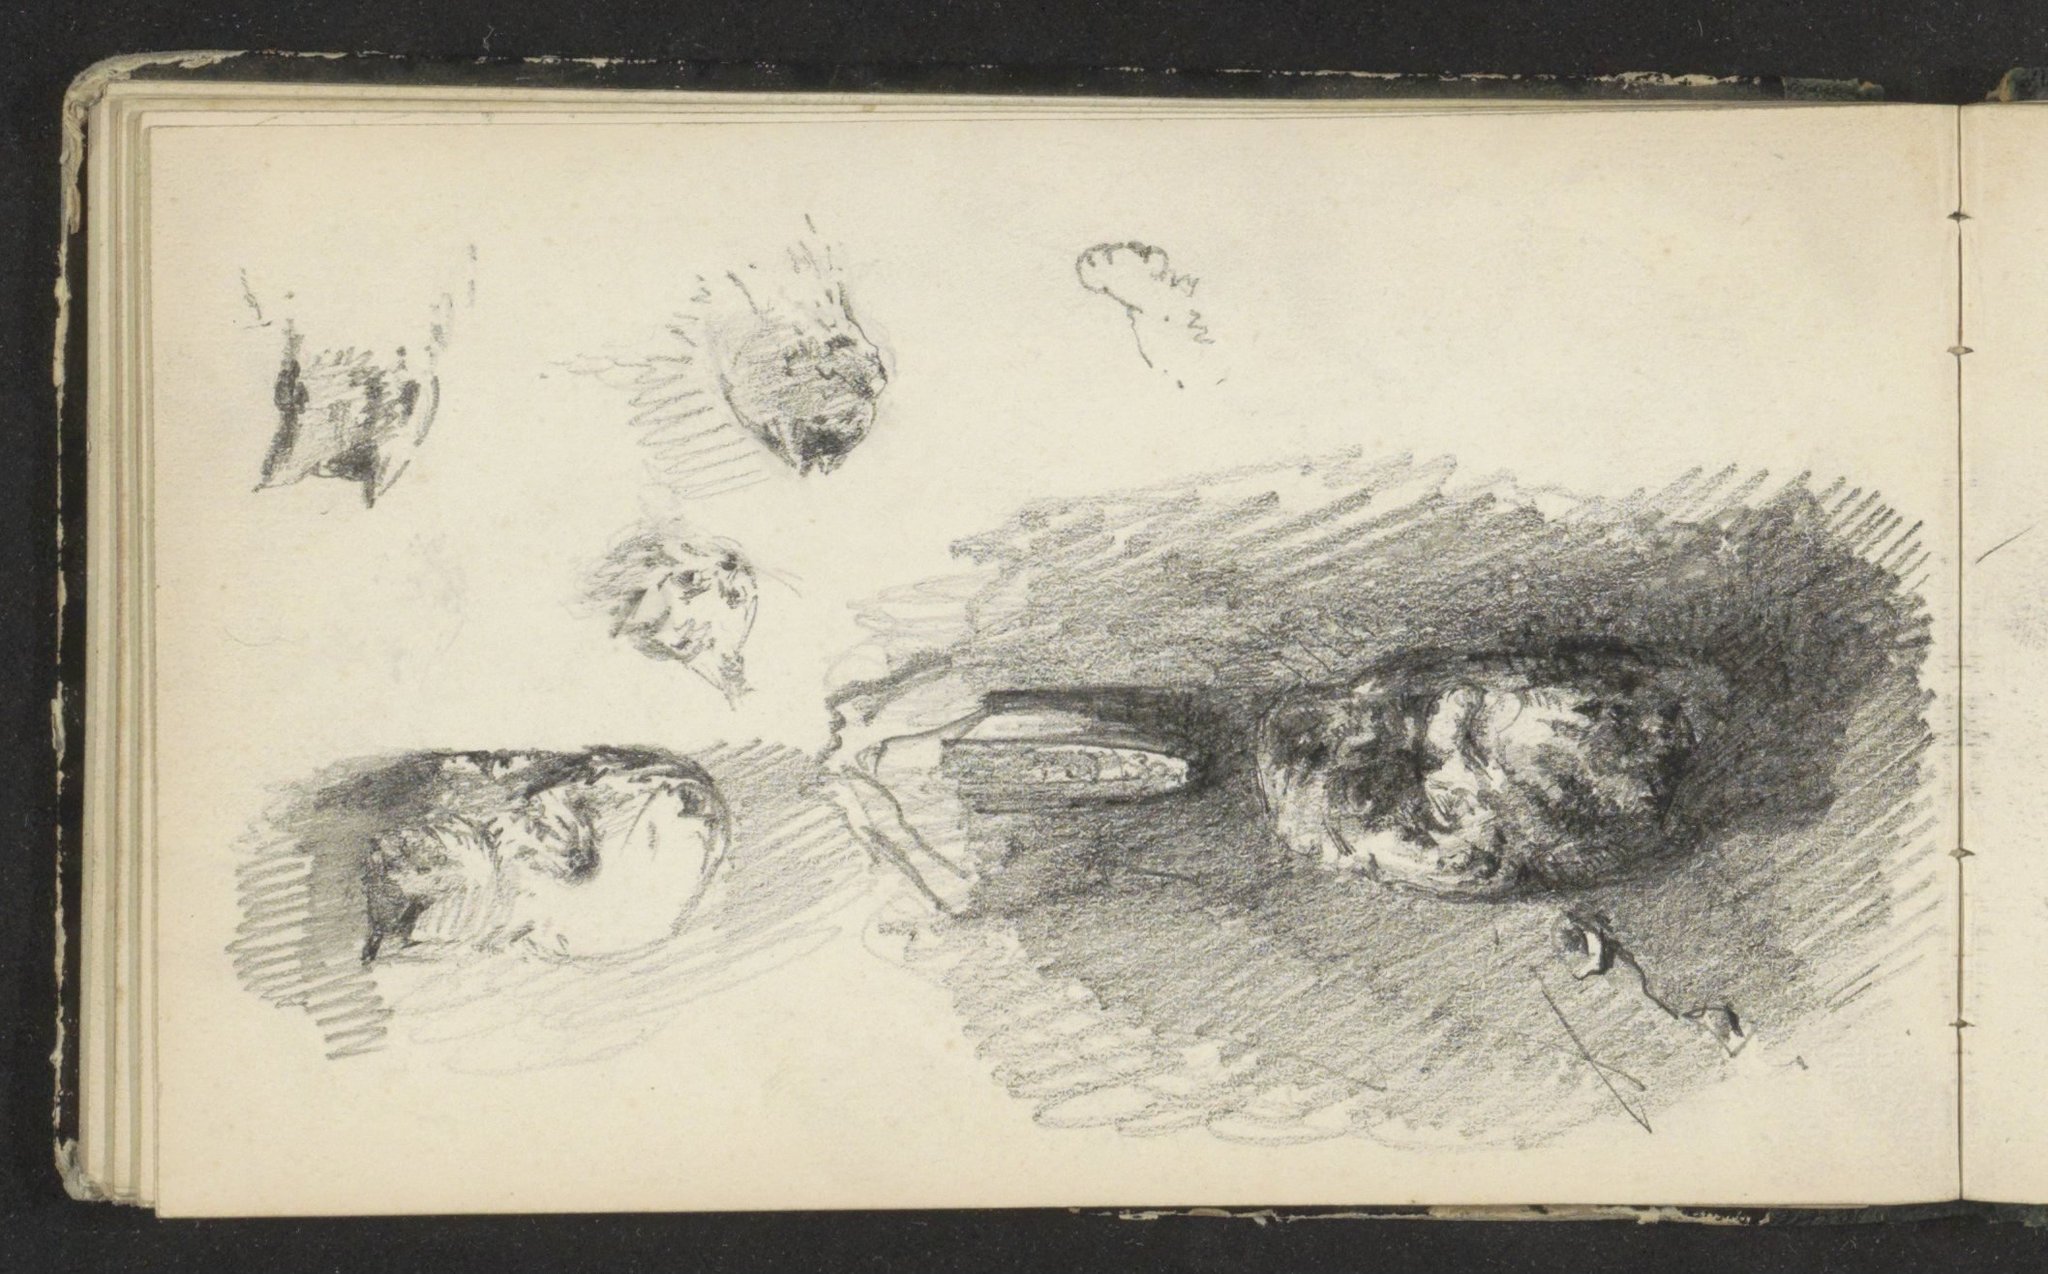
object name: sketchbook leaf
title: Kittens, waaronder een kitten slapend naast een schaal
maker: maria vos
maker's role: draughtsman, painter, print maker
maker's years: 1824-1906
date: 1834-1906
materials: paper, pencil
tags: cat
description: Blad 30 verso uit een schetsboek met 46 bladen.